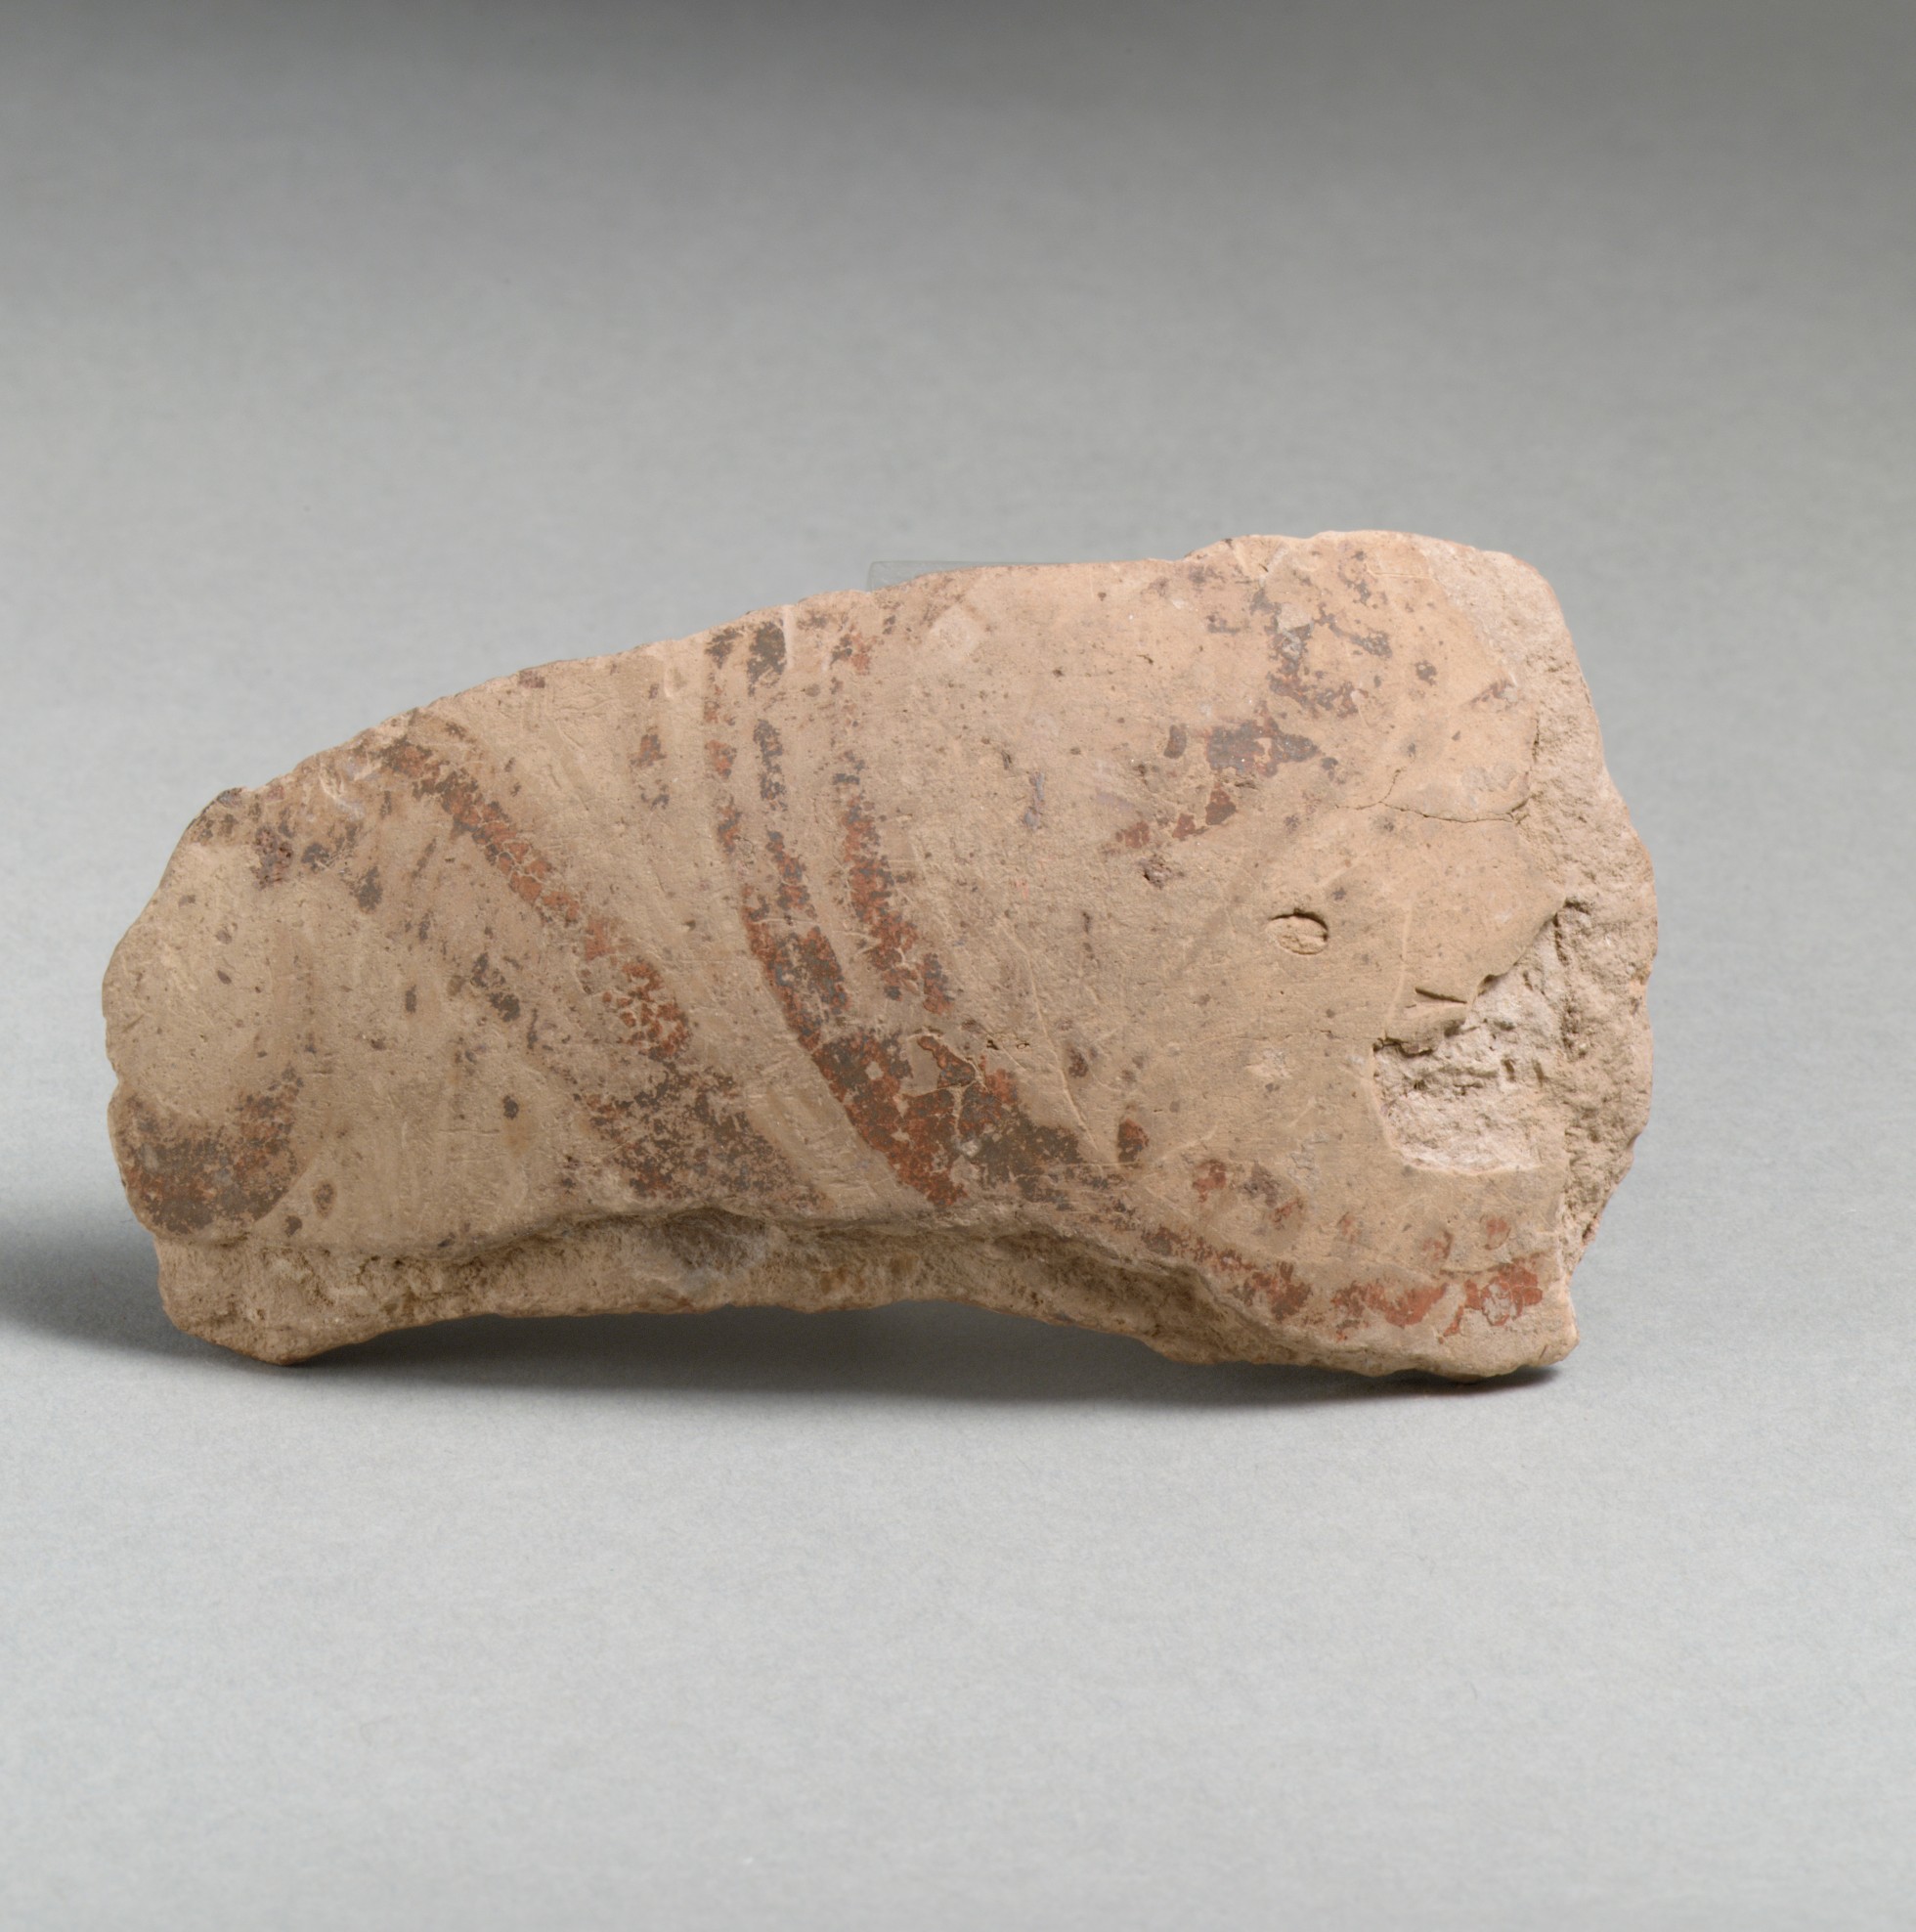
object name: vase fragment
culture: minoan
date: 1600-1450 BCE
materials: terracotta